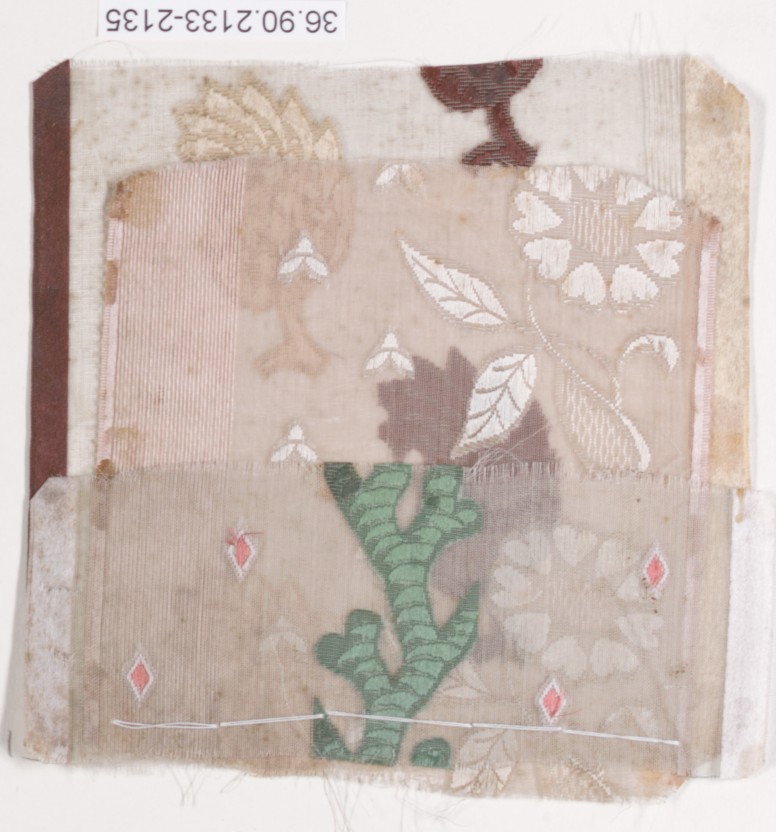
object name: piece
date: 1801-1900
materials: silk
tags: flowers,leaves